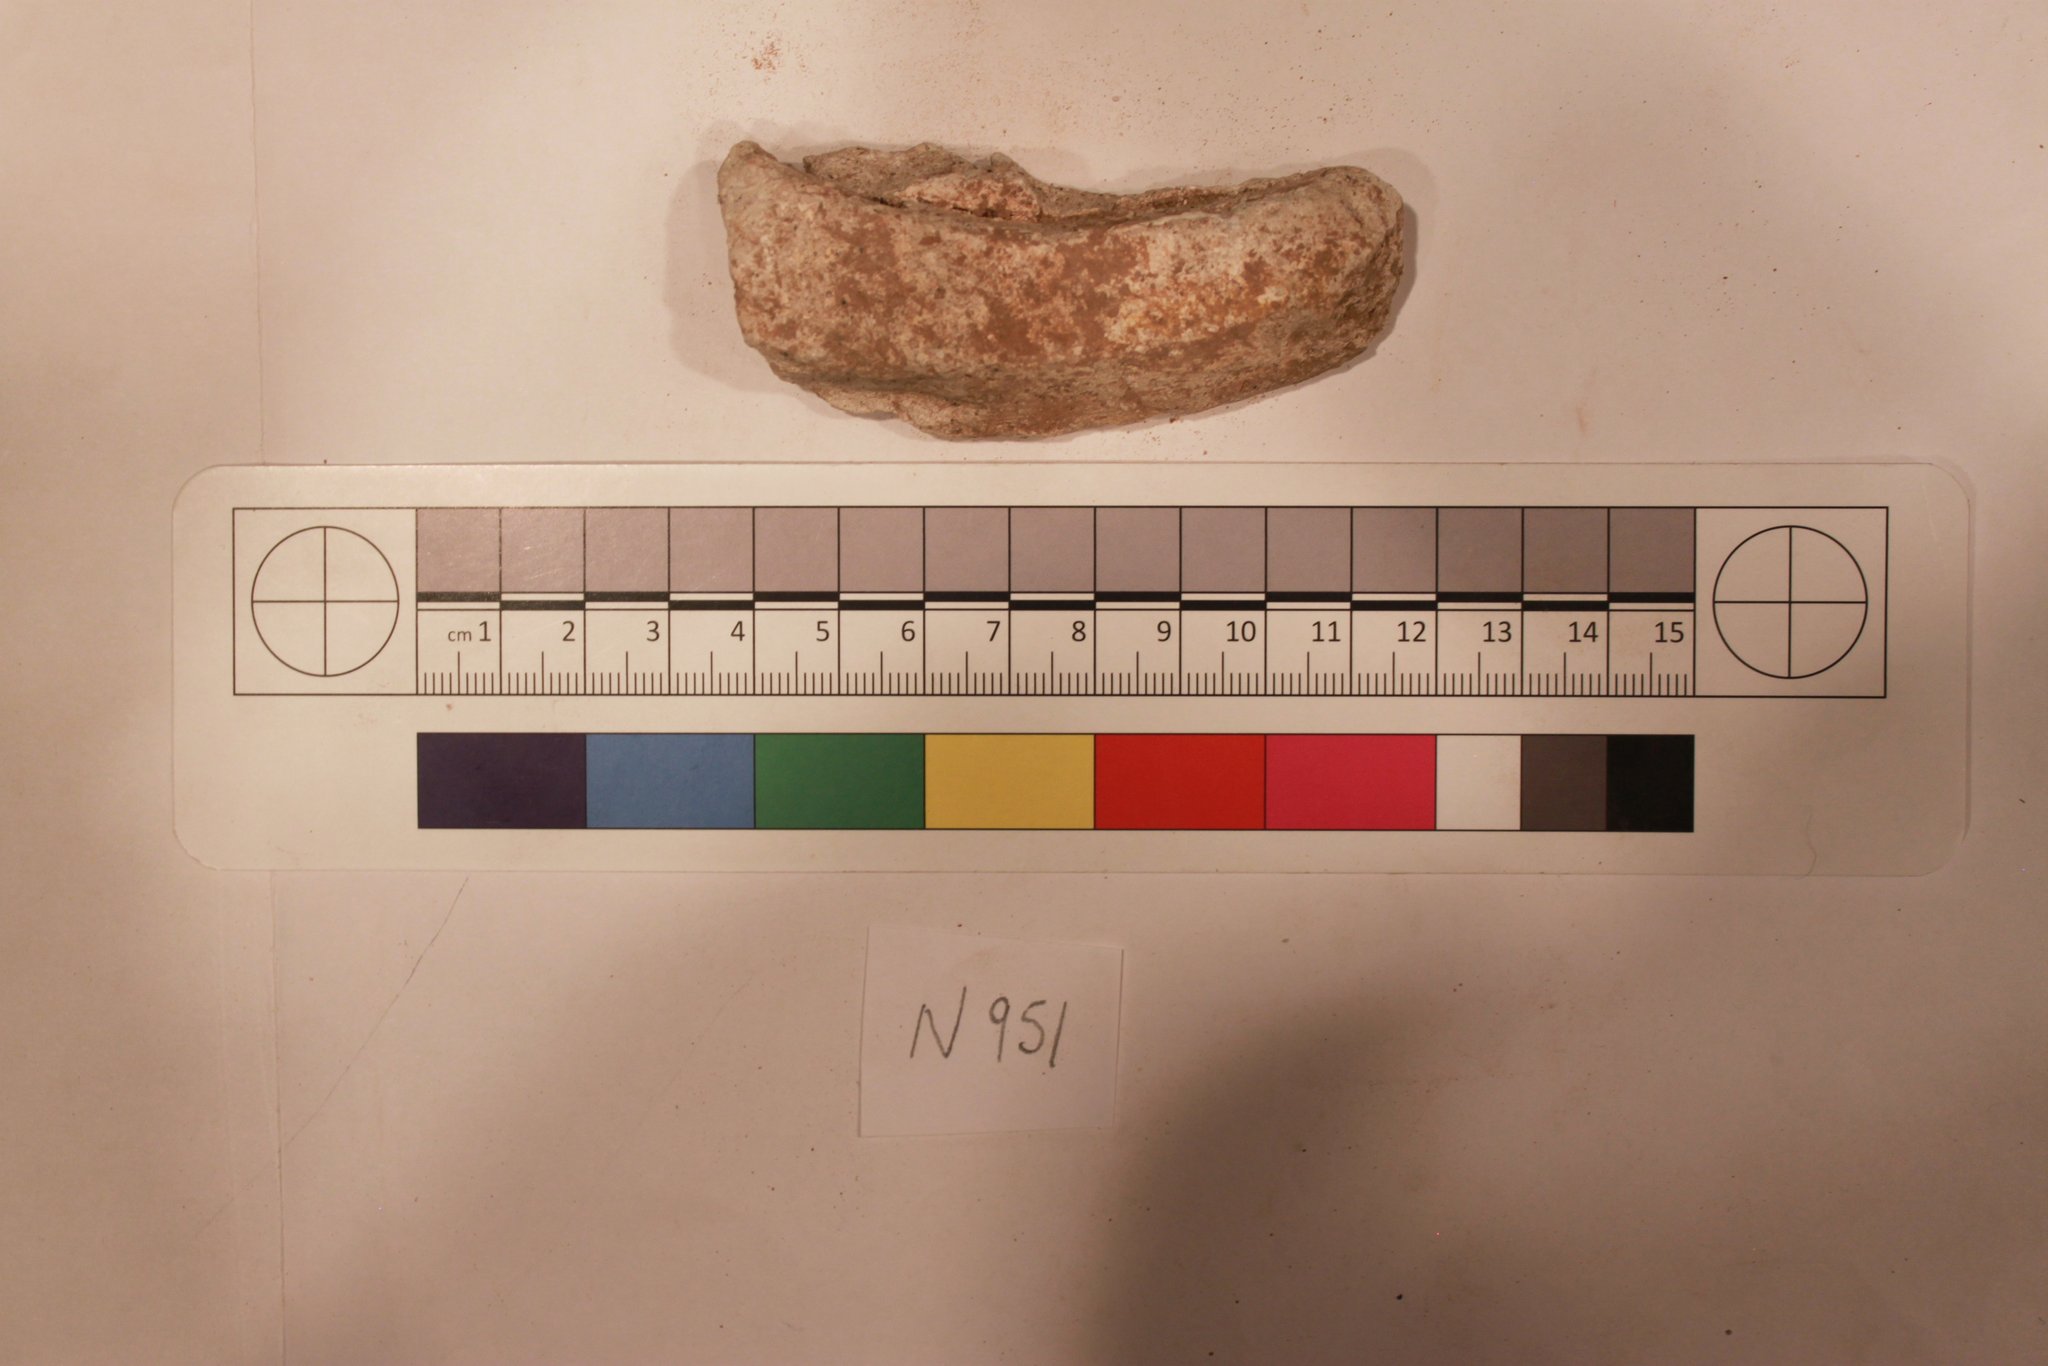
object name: fragment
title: Stucco Fragment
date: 701-1200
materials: plaster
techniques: carving, painting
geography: iran